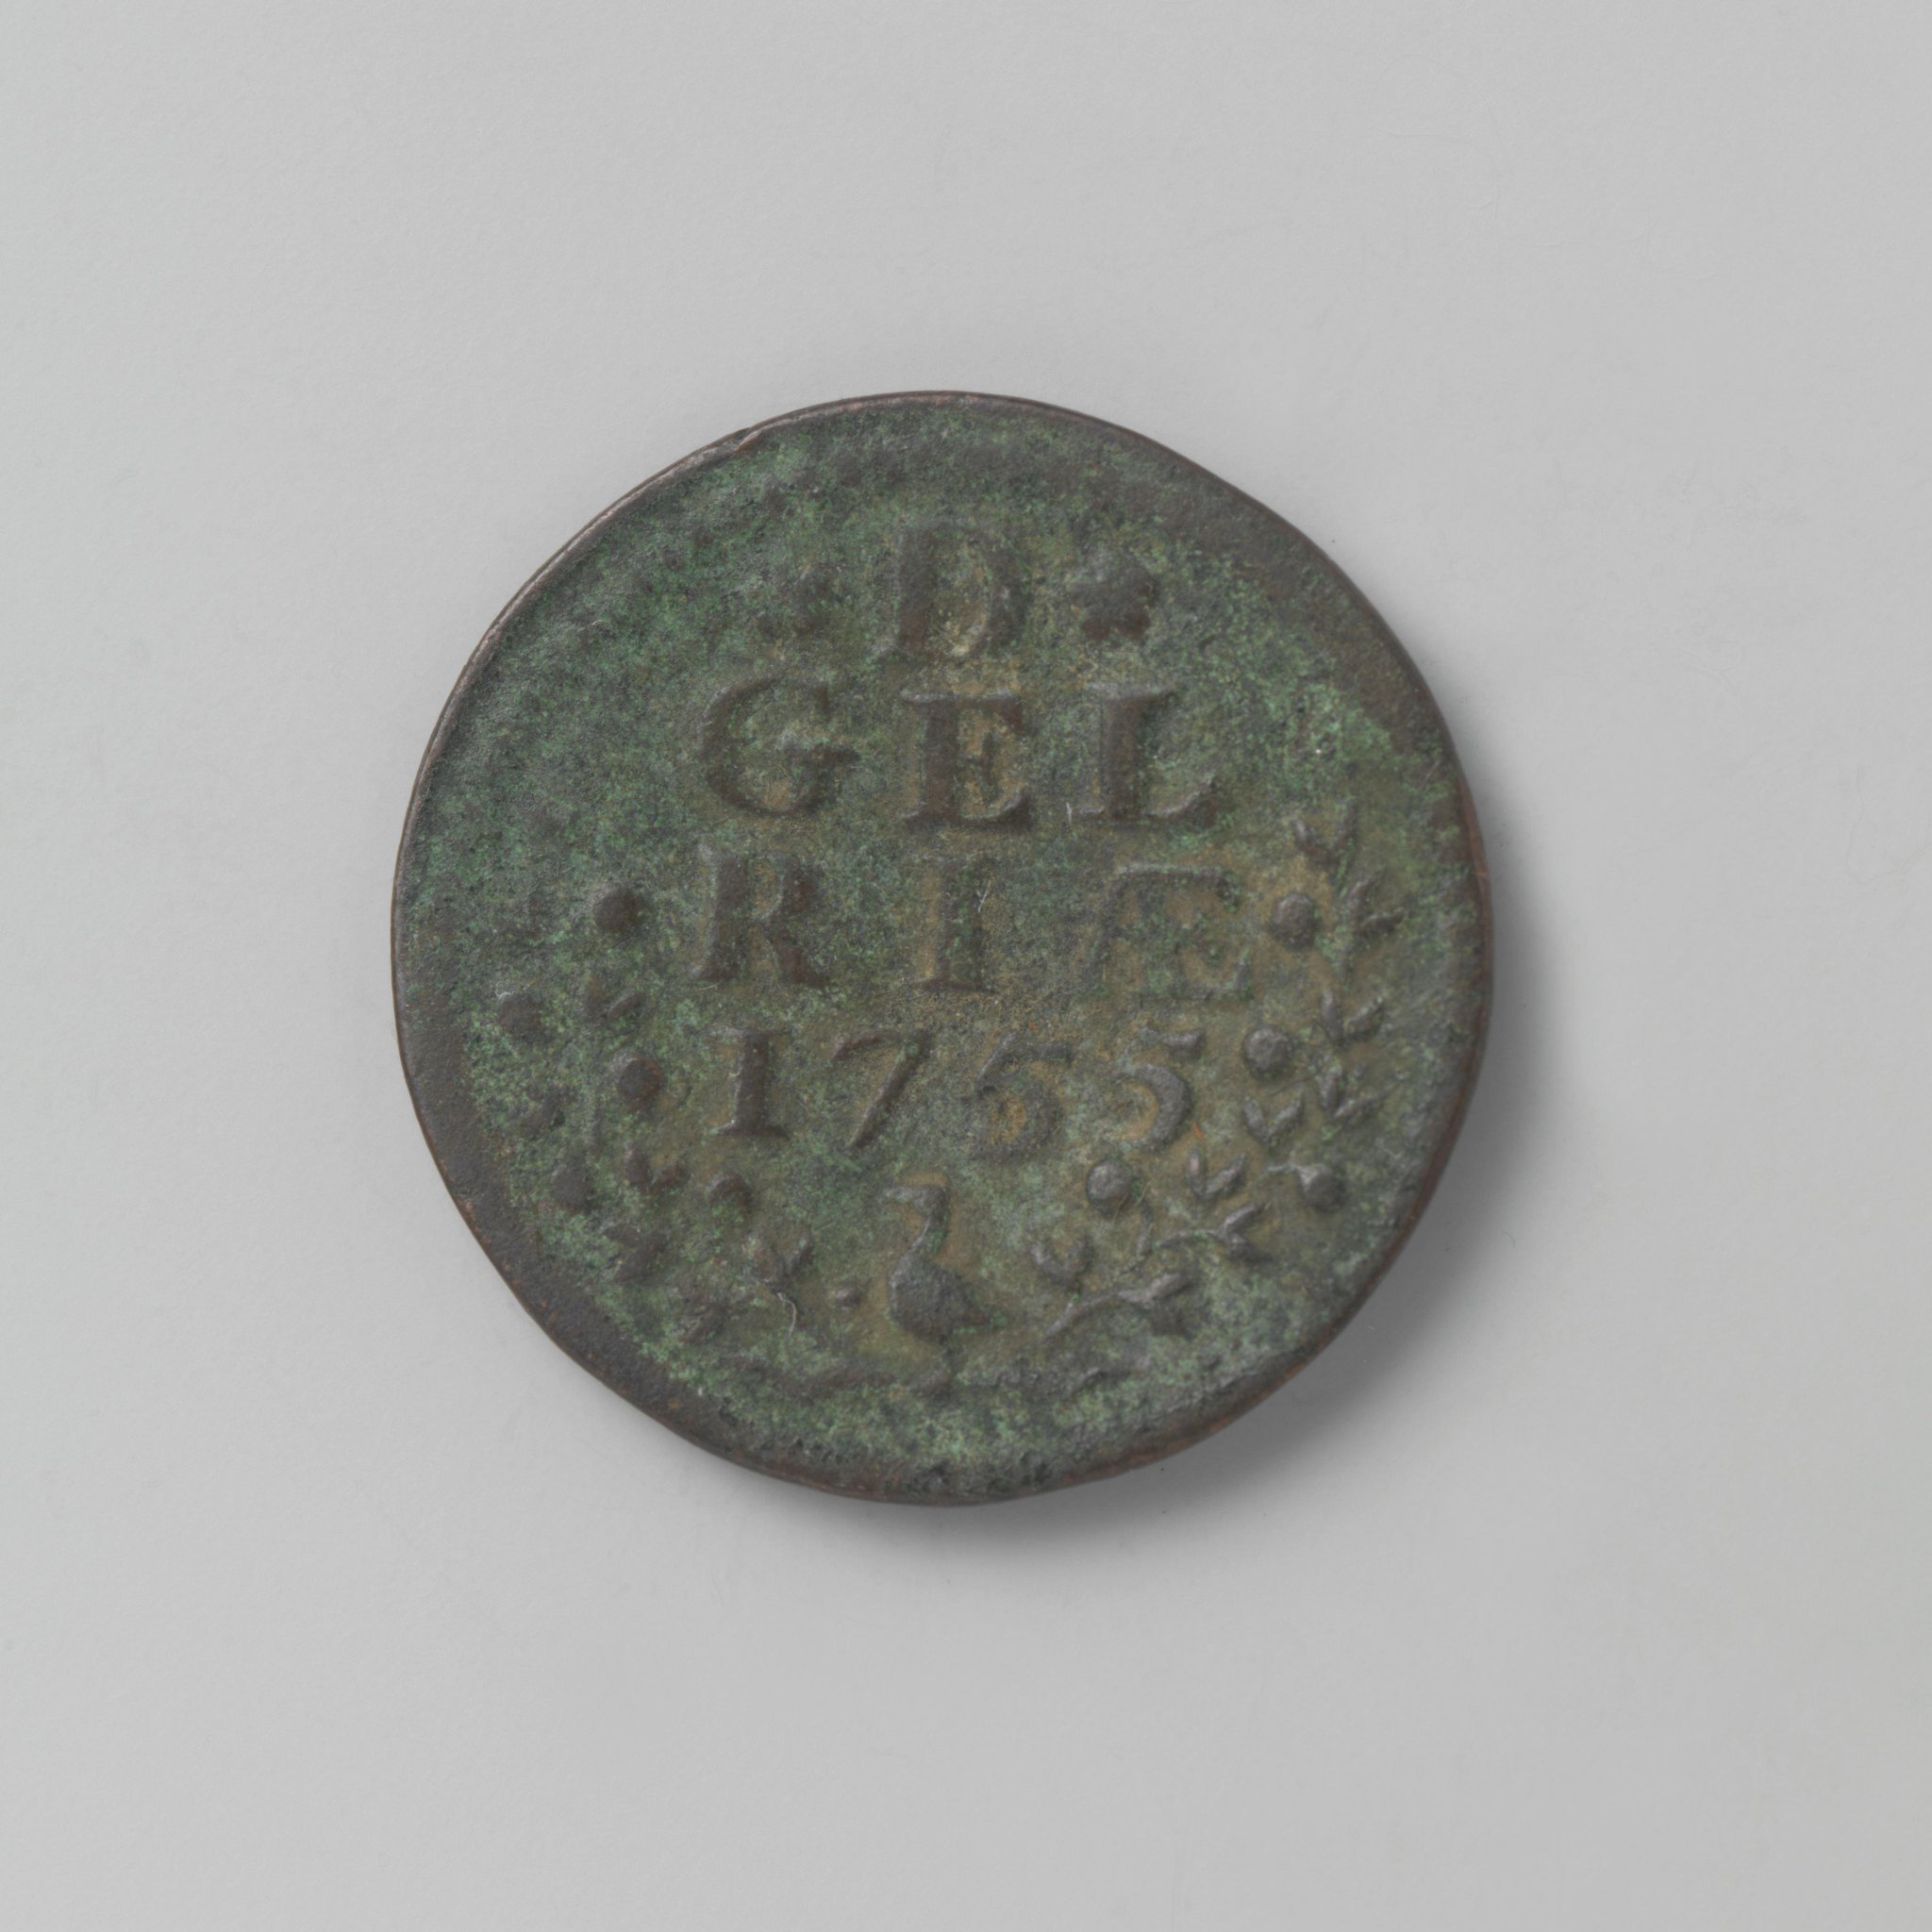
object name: coin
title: Gelderland, duit, 1755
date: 1755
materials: copper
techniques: striking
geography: harderwijk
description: Koperen munt. Voorzijde: binnen versiering in drie regels D/GEL/RIAE, daaronder jaartal en muntmeesterteken. Keerzijde: gekroond Gelders wapenschild.